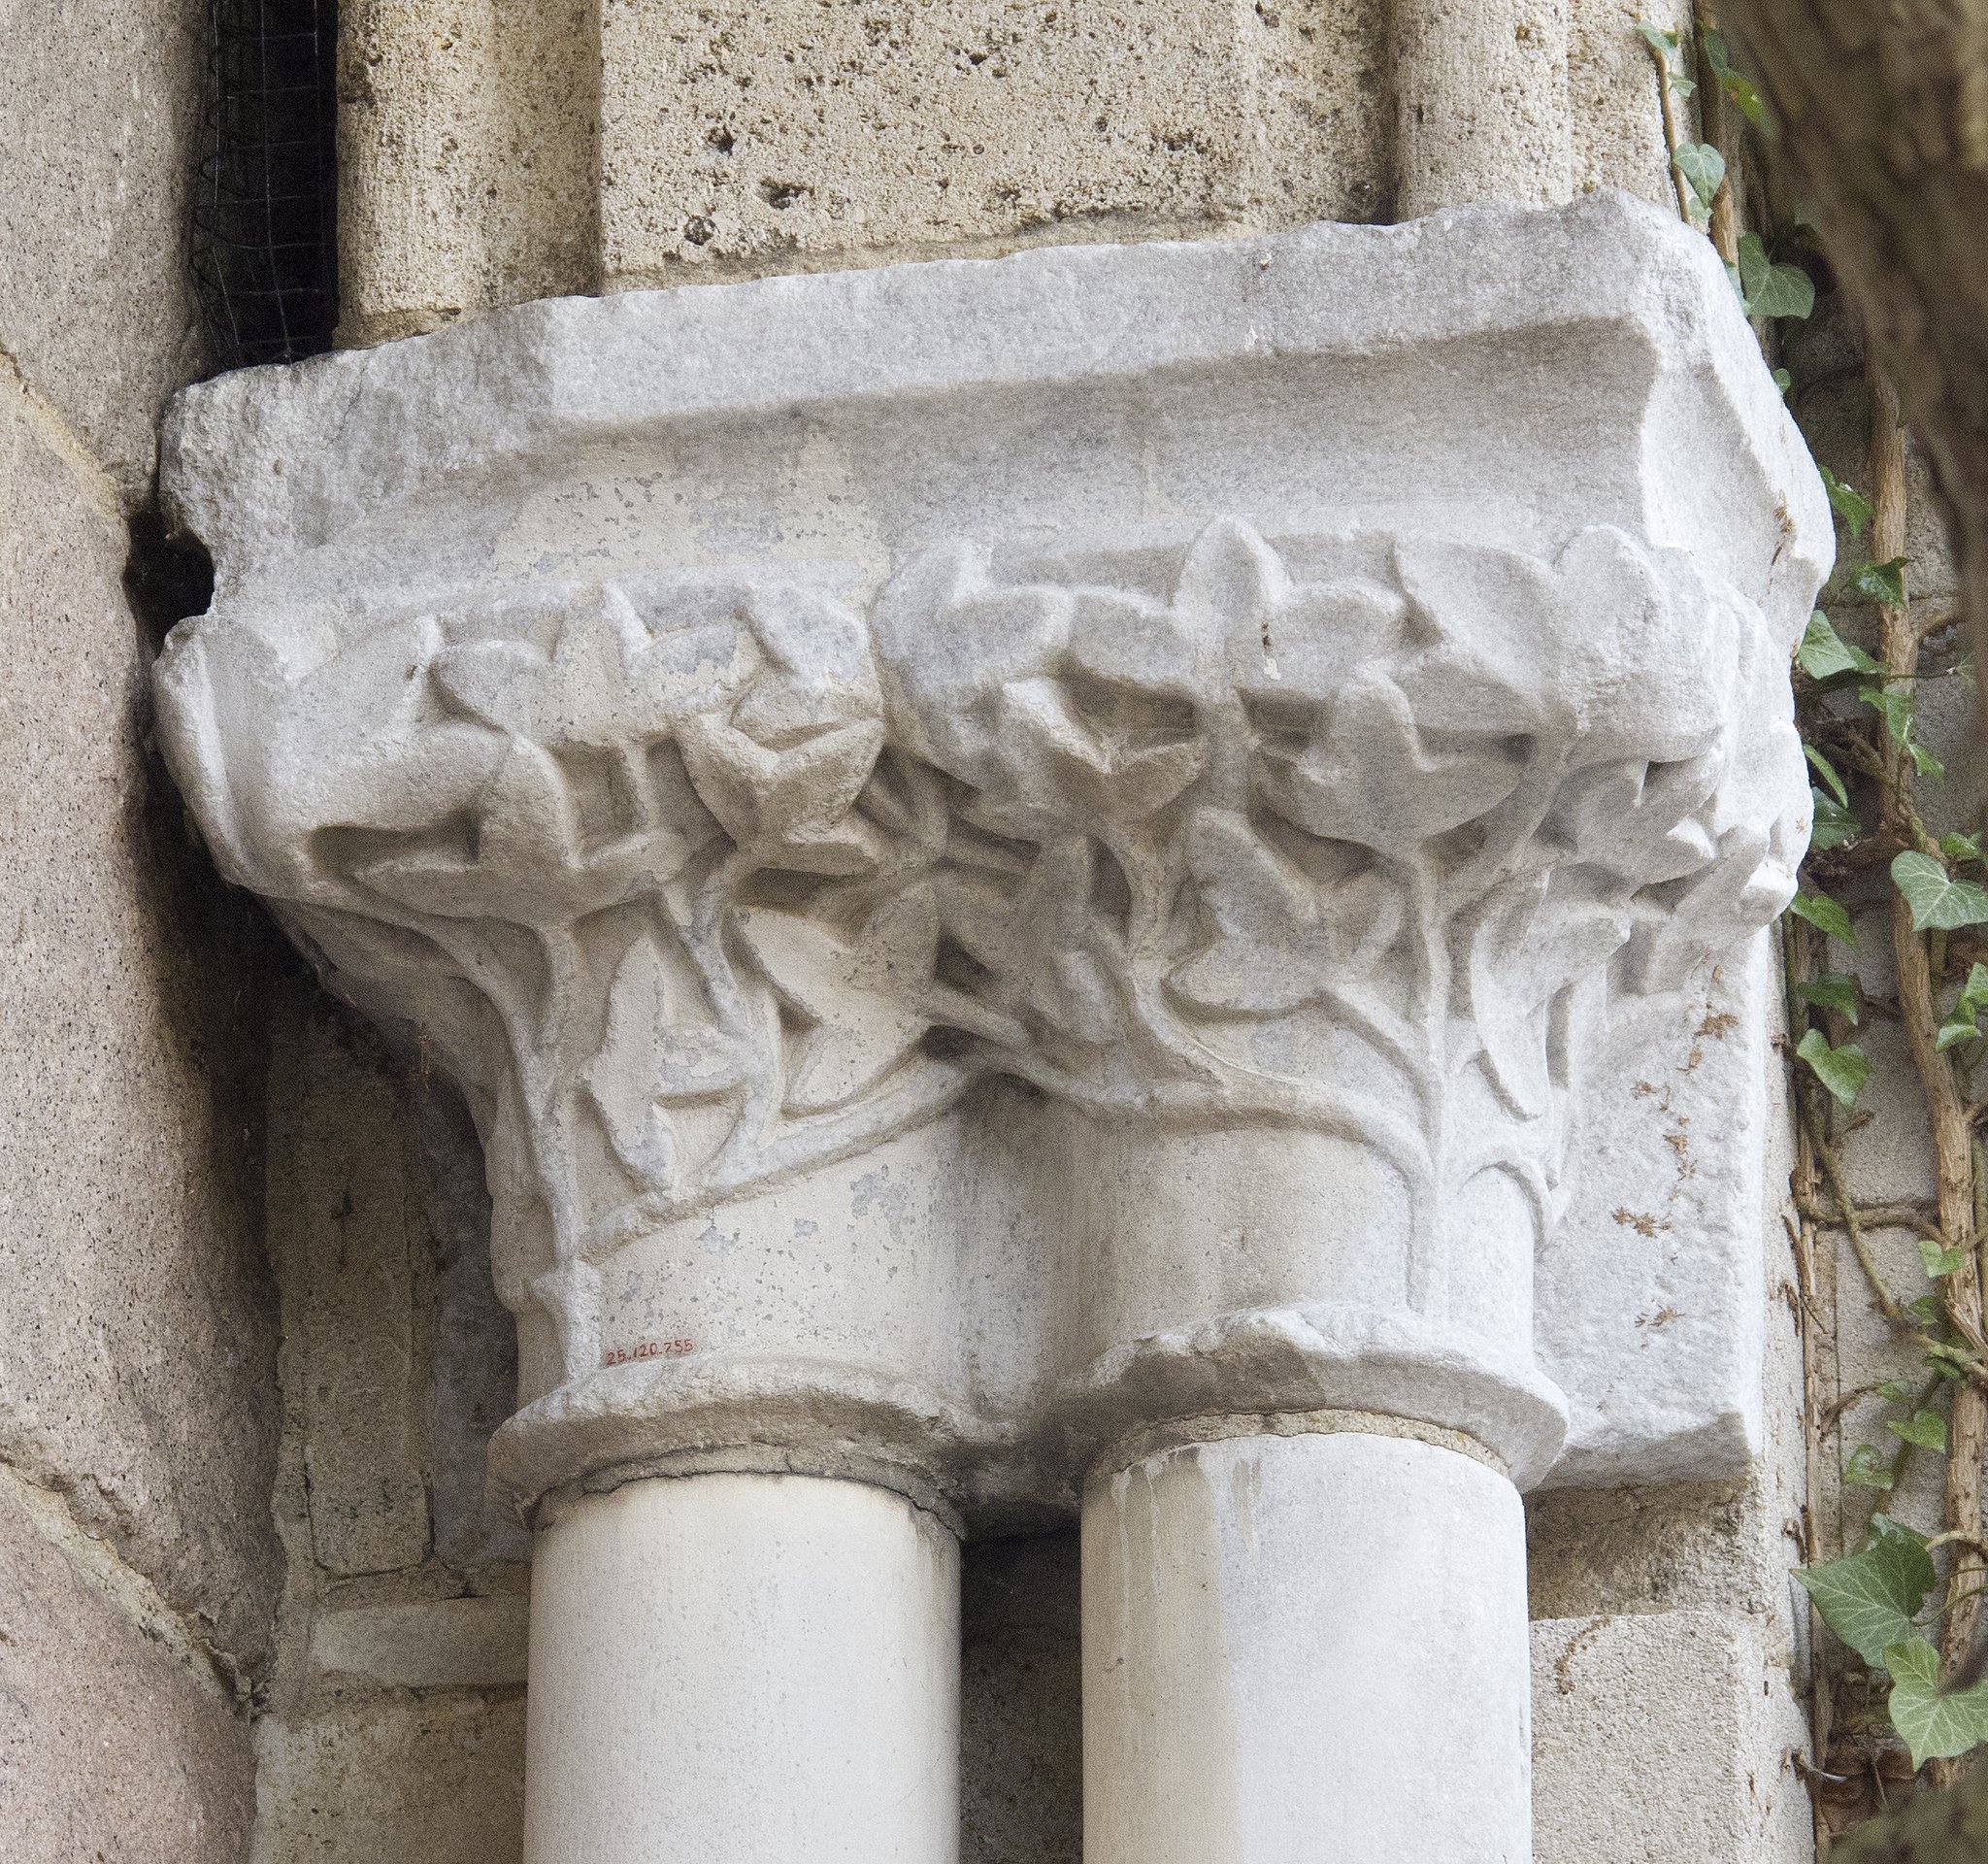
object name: capital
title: Double Capital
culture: french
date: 1267-1333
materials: marble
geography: france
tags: leaves